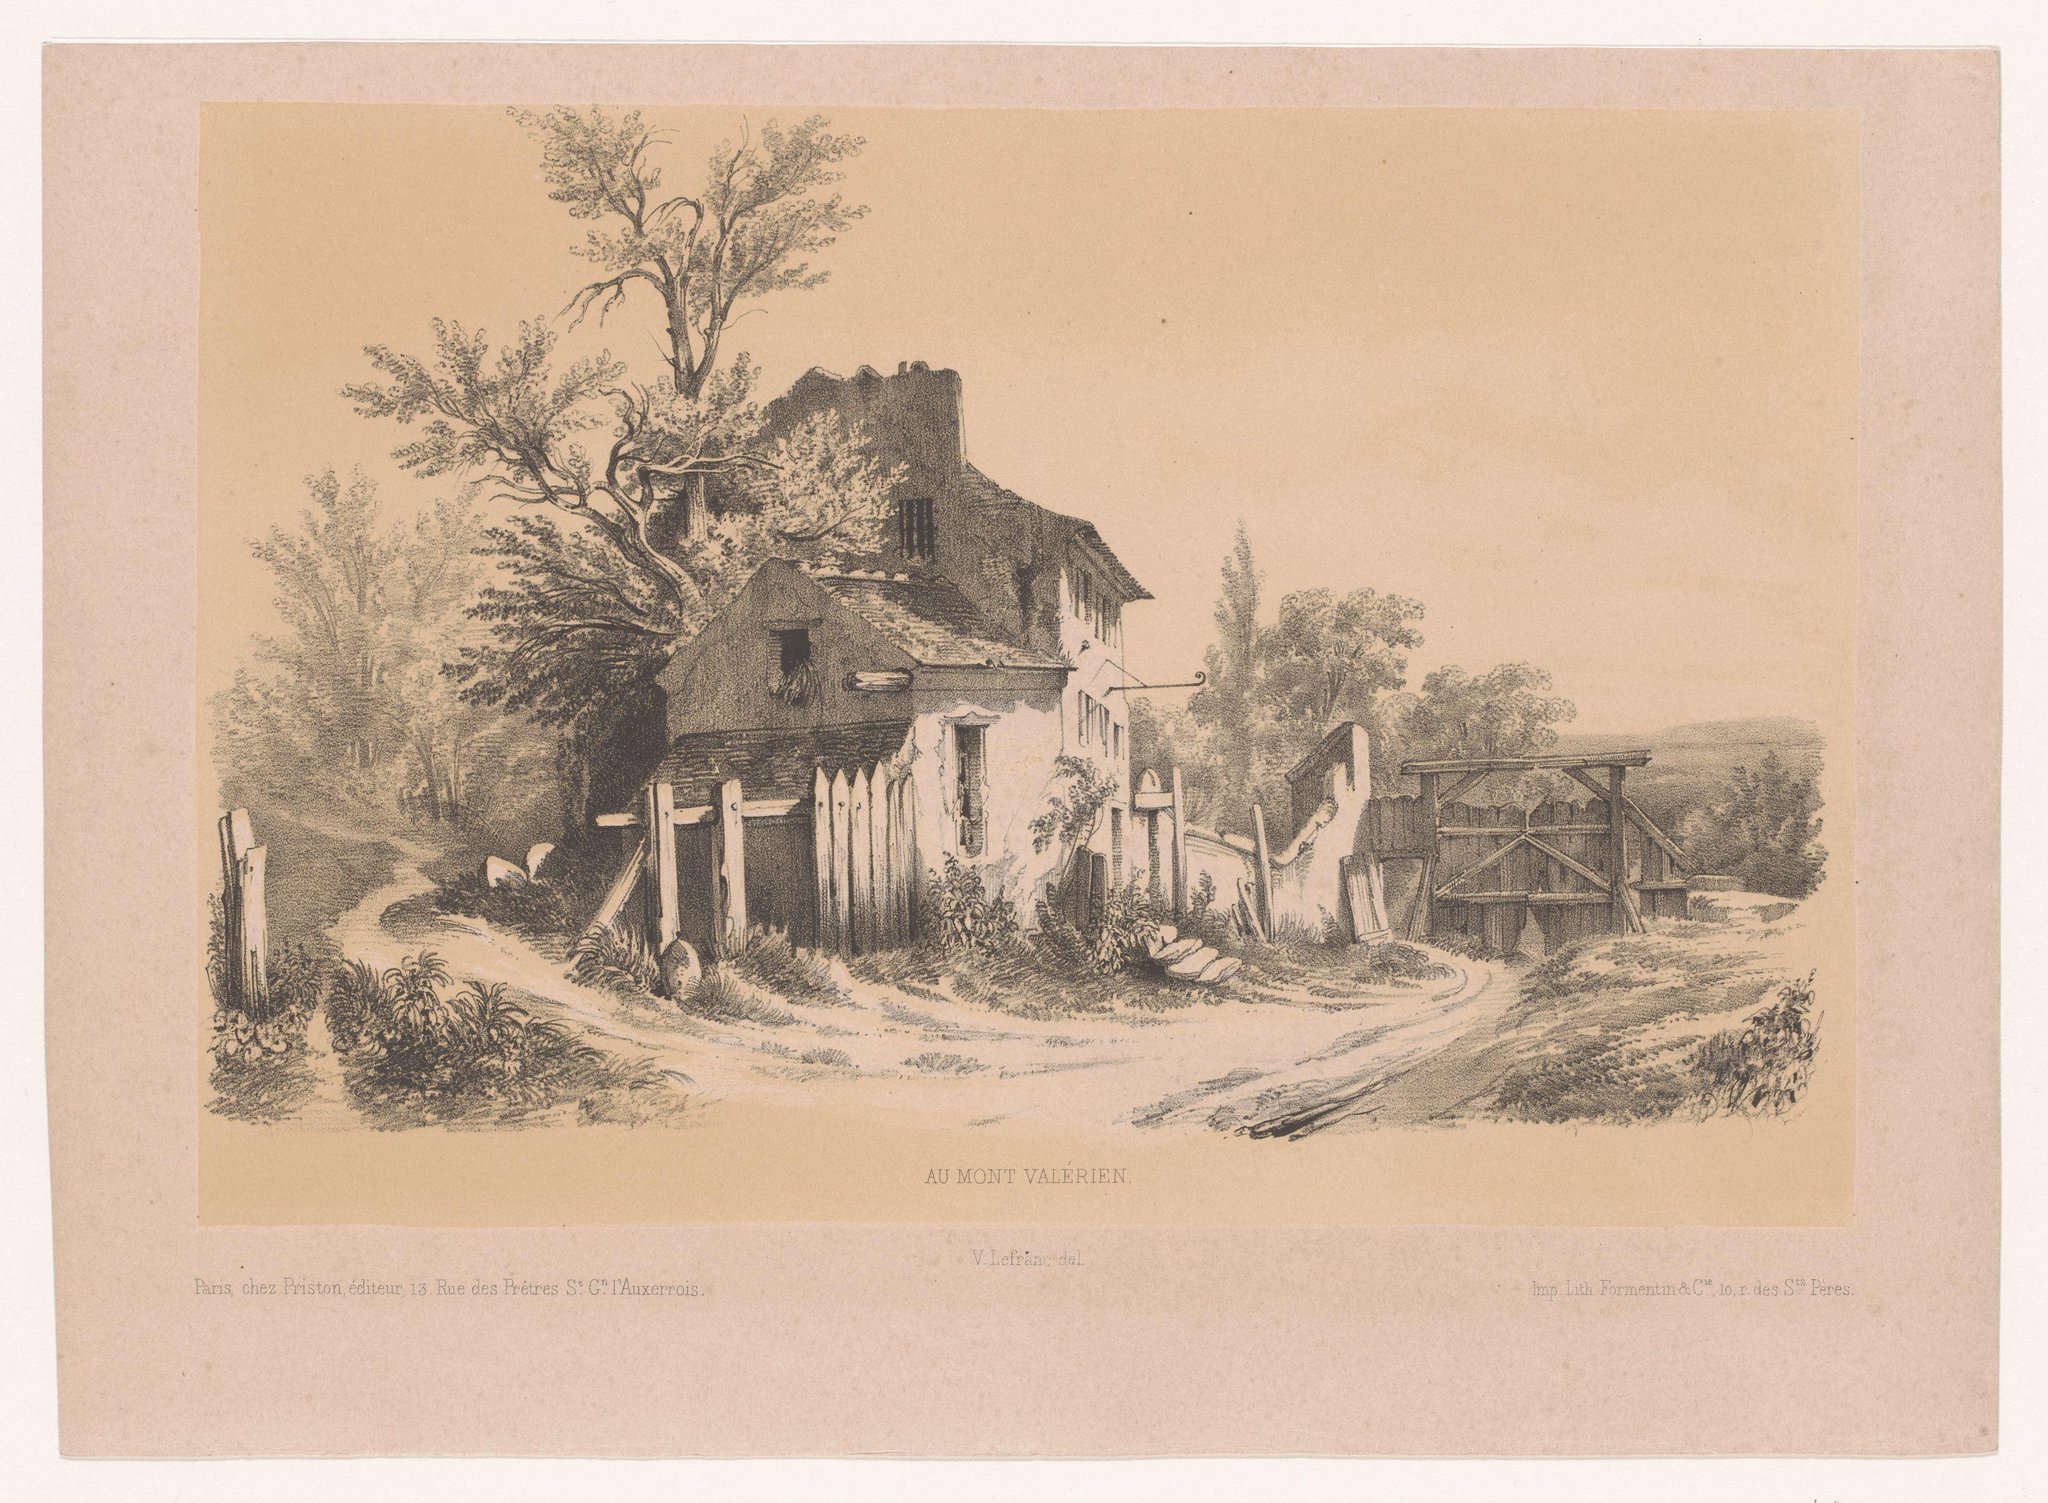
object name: print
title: Au mont Valérien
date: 1833-1843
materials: paper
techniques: tone lithography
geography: paris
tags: farm or solitary house in landscape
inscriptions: collector's mark: Lugt 2228a